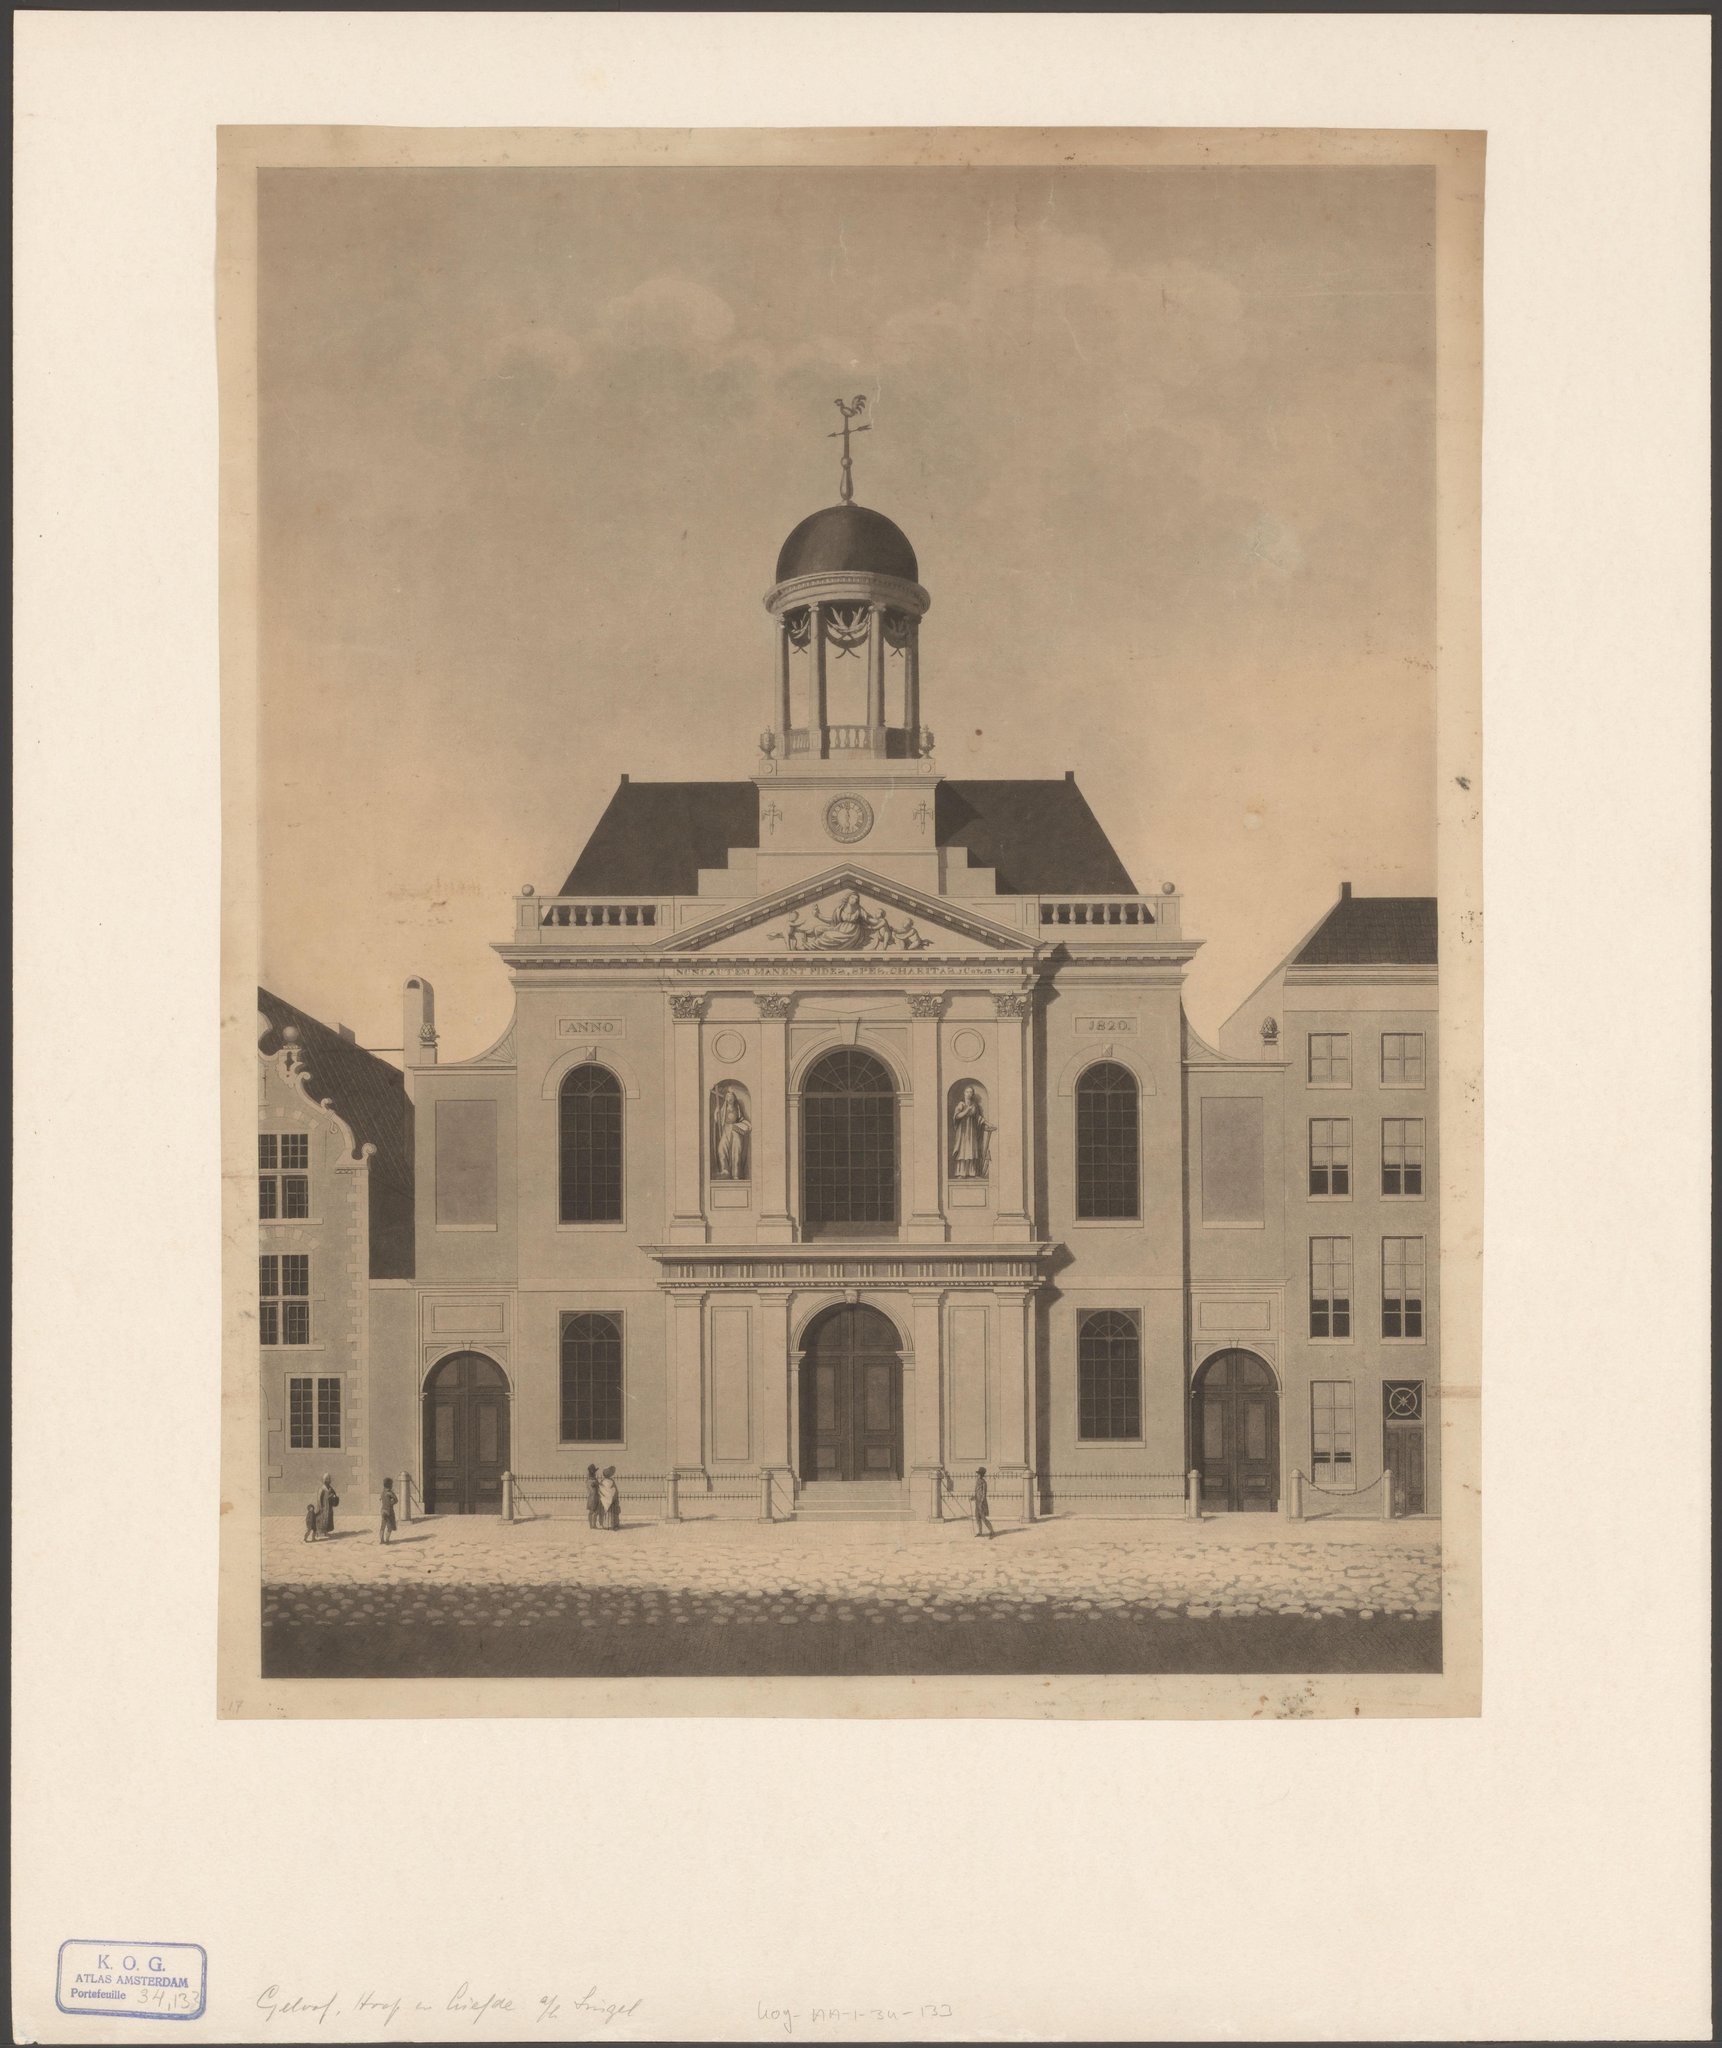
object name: print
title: Gezicht op de Sint-Catharinakerk te Amsterdam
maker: Anonymous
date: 1820-1850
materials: paper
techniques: aquatint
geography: netherlands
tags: church (exterior), street (+ city(-scape) with figures, staffage)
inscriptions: collector's mark: Lugt 1641b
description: Onderwerpsrubriek binnen de Atlas Amsterdam: Kerkwezen: R.K. Gemeenten: Begijnhof t/m Petrus en Paulus.